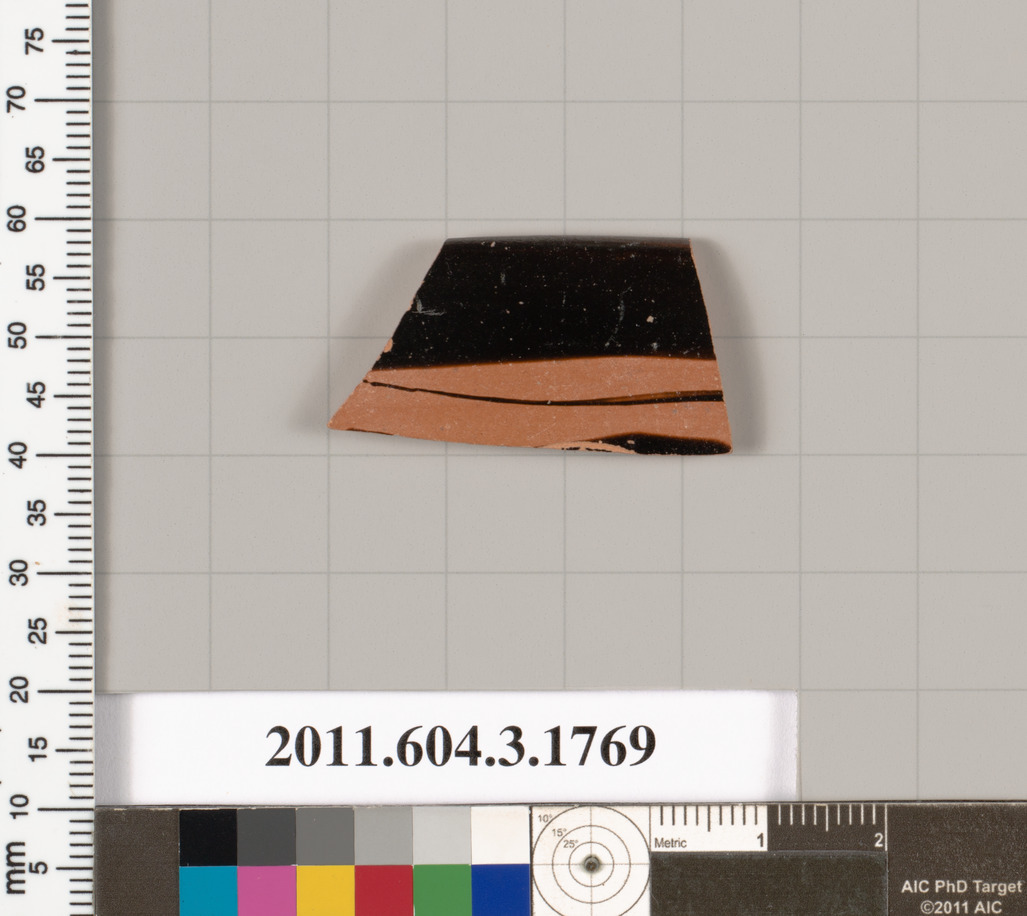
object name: kylix fragment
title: Terracotta rim fragment of a kylix: Band cup (drinking cup)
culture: greek, attic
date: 520-510 BCE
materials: terracotta